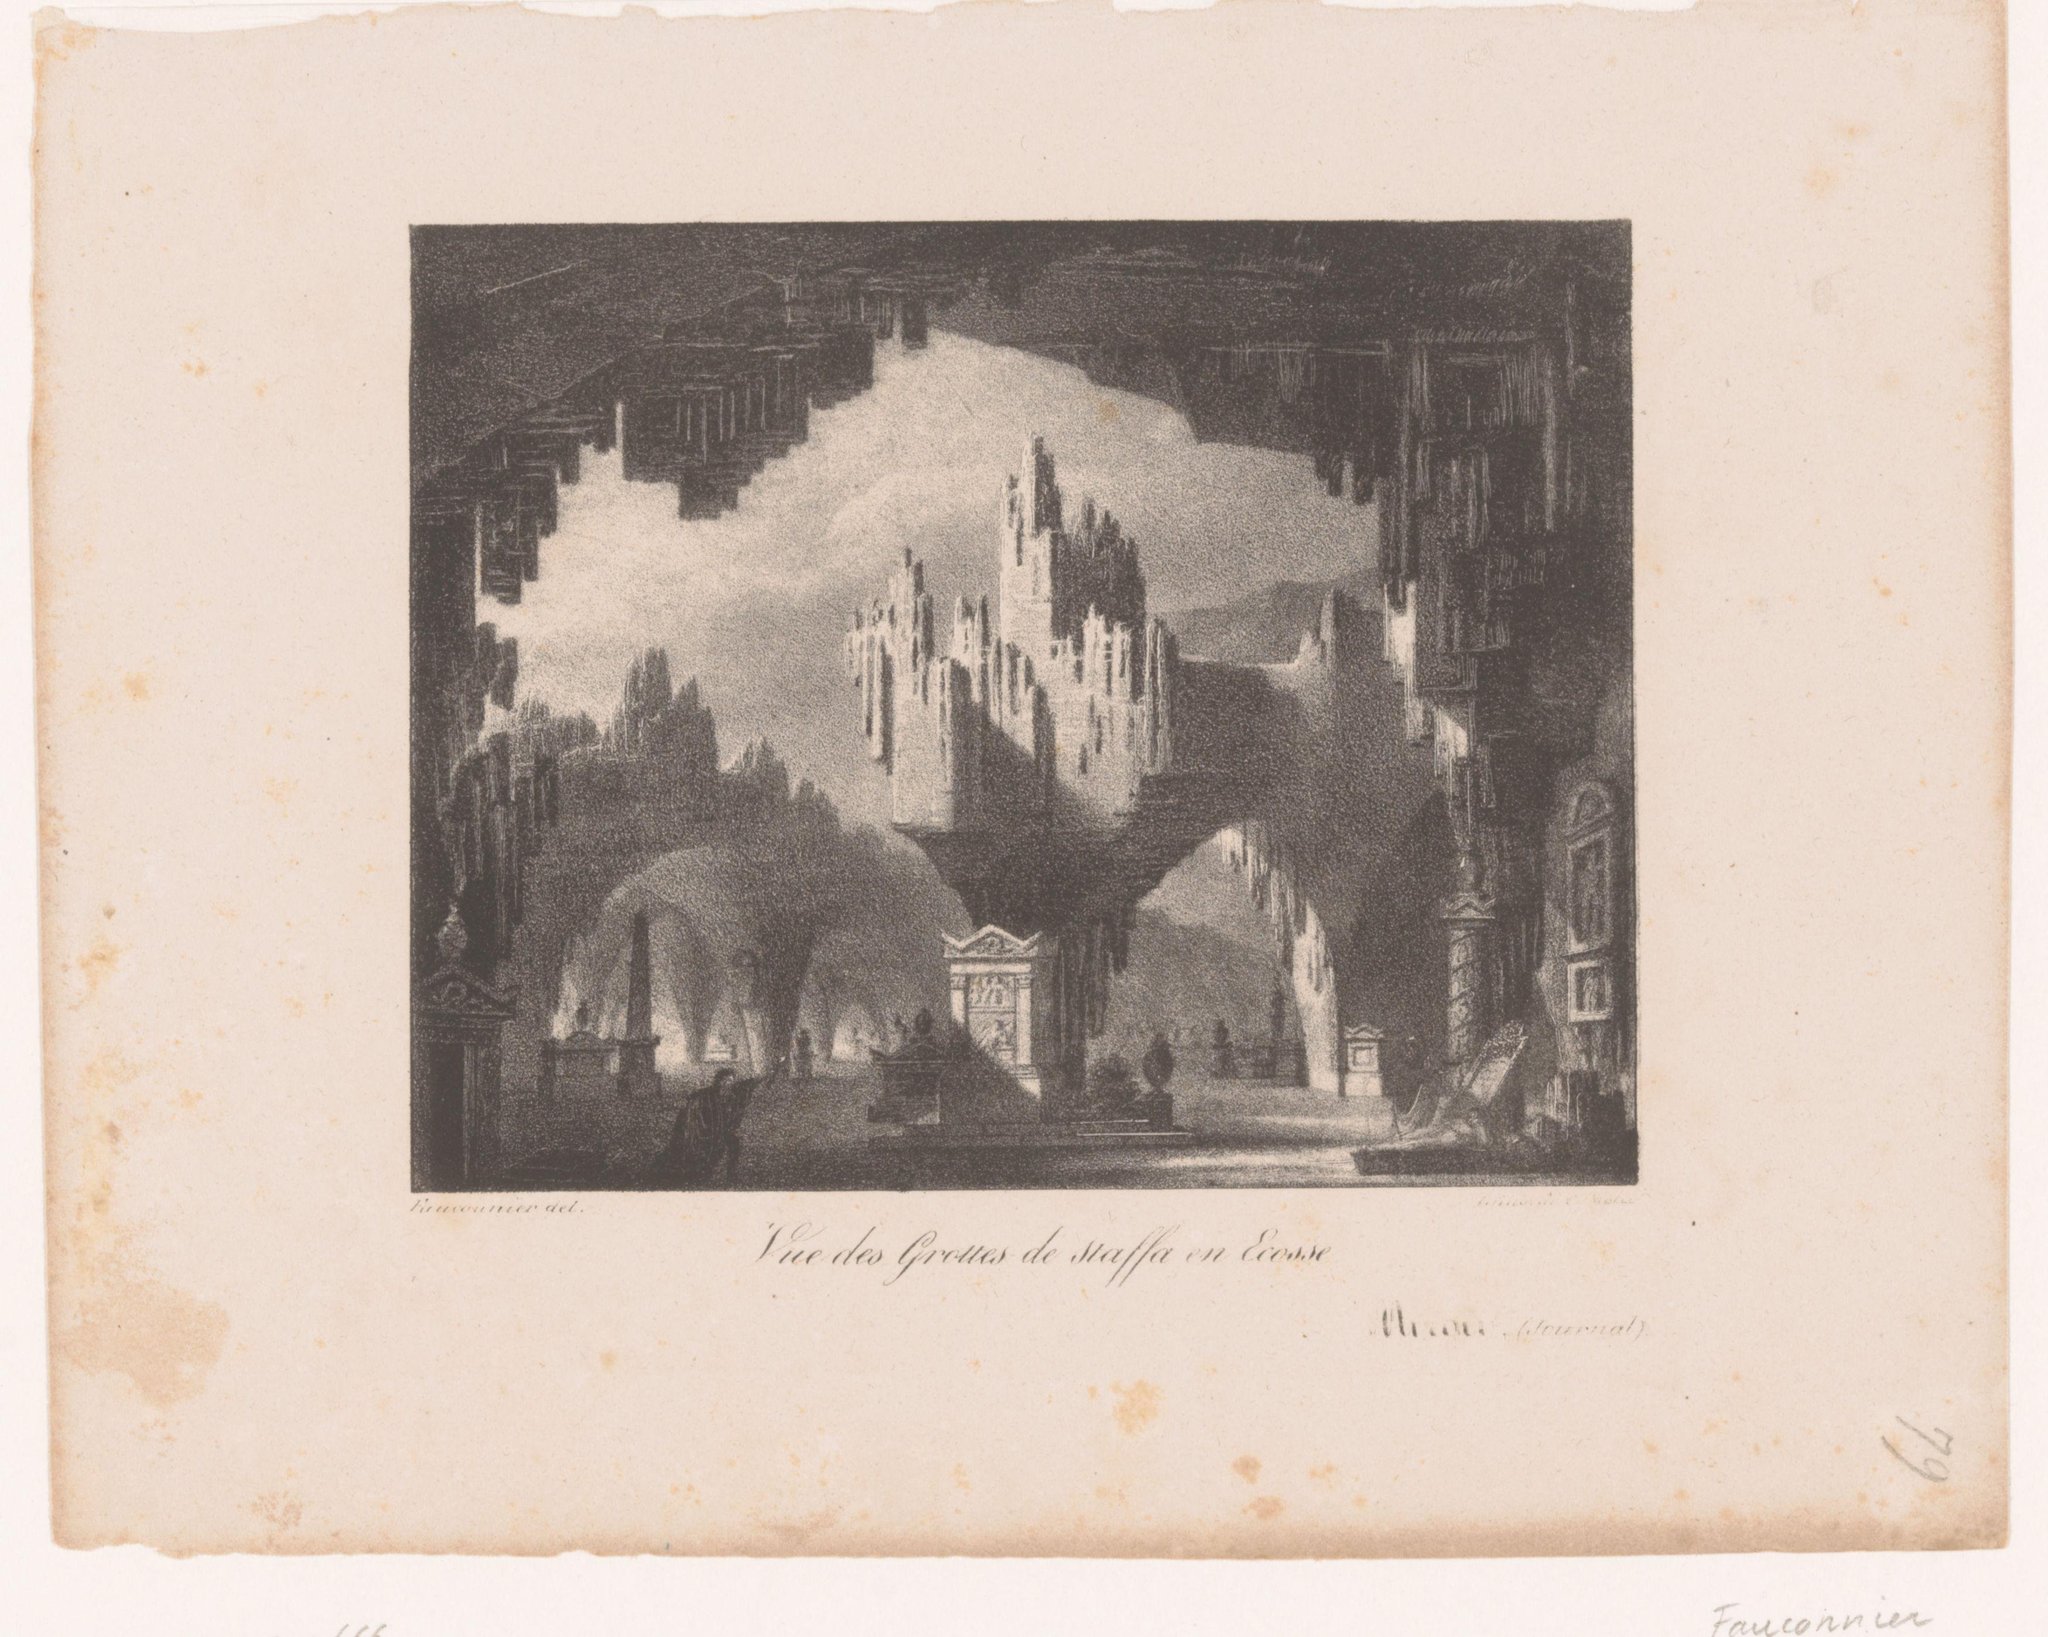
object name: print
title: Vue des Grottes de Staffa en Ecosse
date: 1821-1823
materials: paper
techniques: lithograph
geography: paris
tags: cave, grotto (+ landscape with figures, staffage)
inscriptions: collector's mark: Lugt 2228a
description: Prent gebruikt in: Le Miroir des spectacles, des lettres, des mœurs et des arts, 1821-1823.